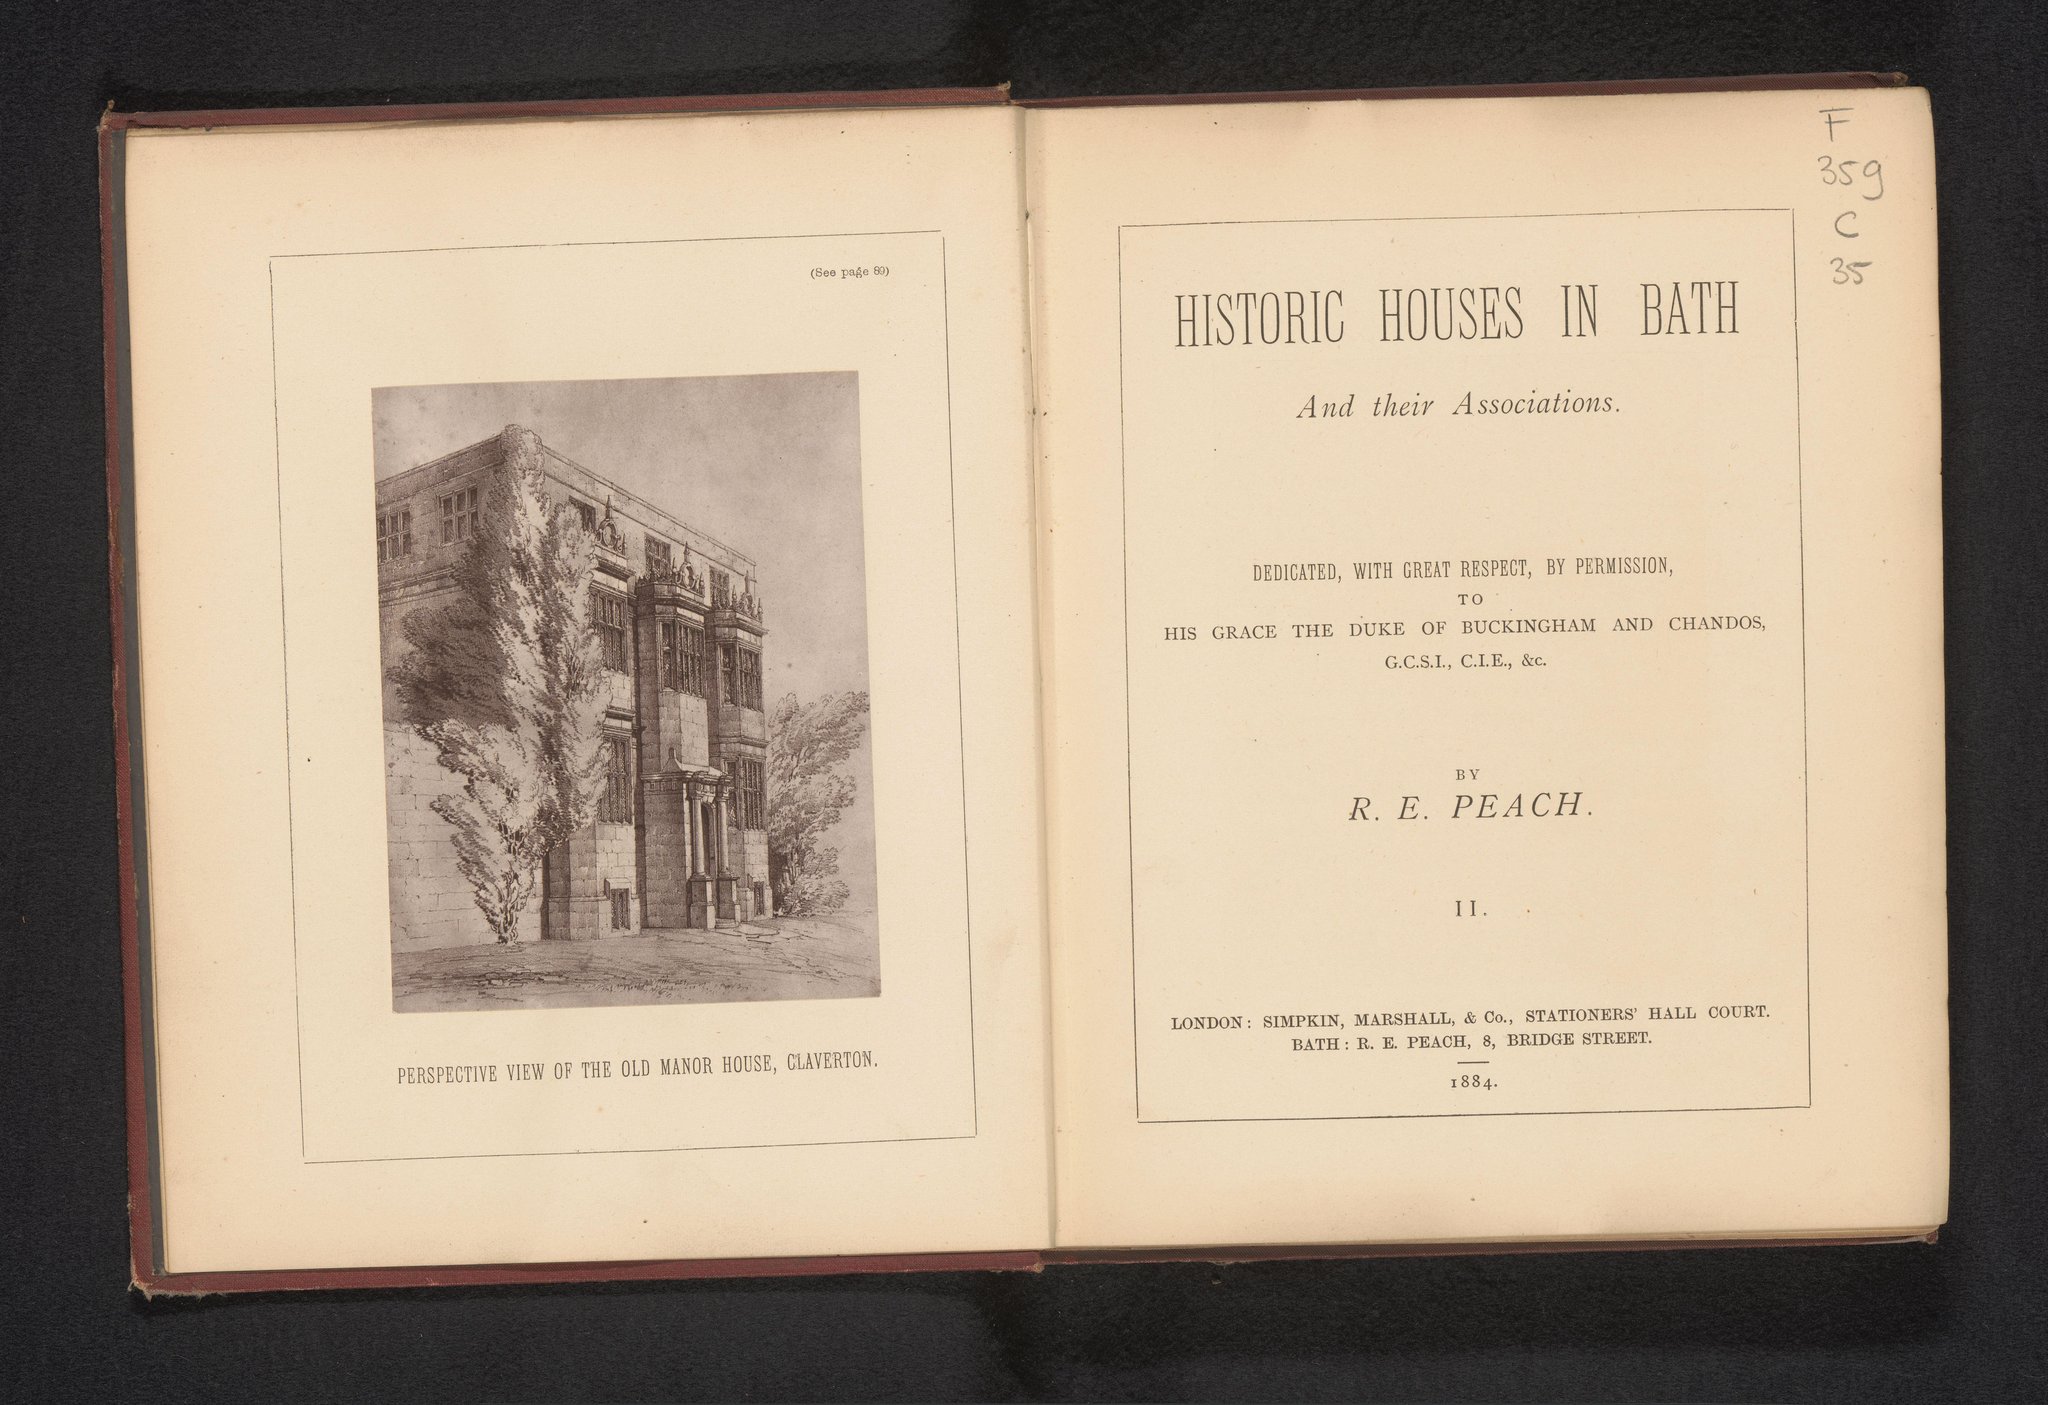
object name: page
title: Perspective View of the Old Manor House, Claverton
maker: Anonymous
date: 1879-1884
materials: paper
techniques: woodburytype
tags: villa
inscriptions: inscription: ‘(See page 89)’